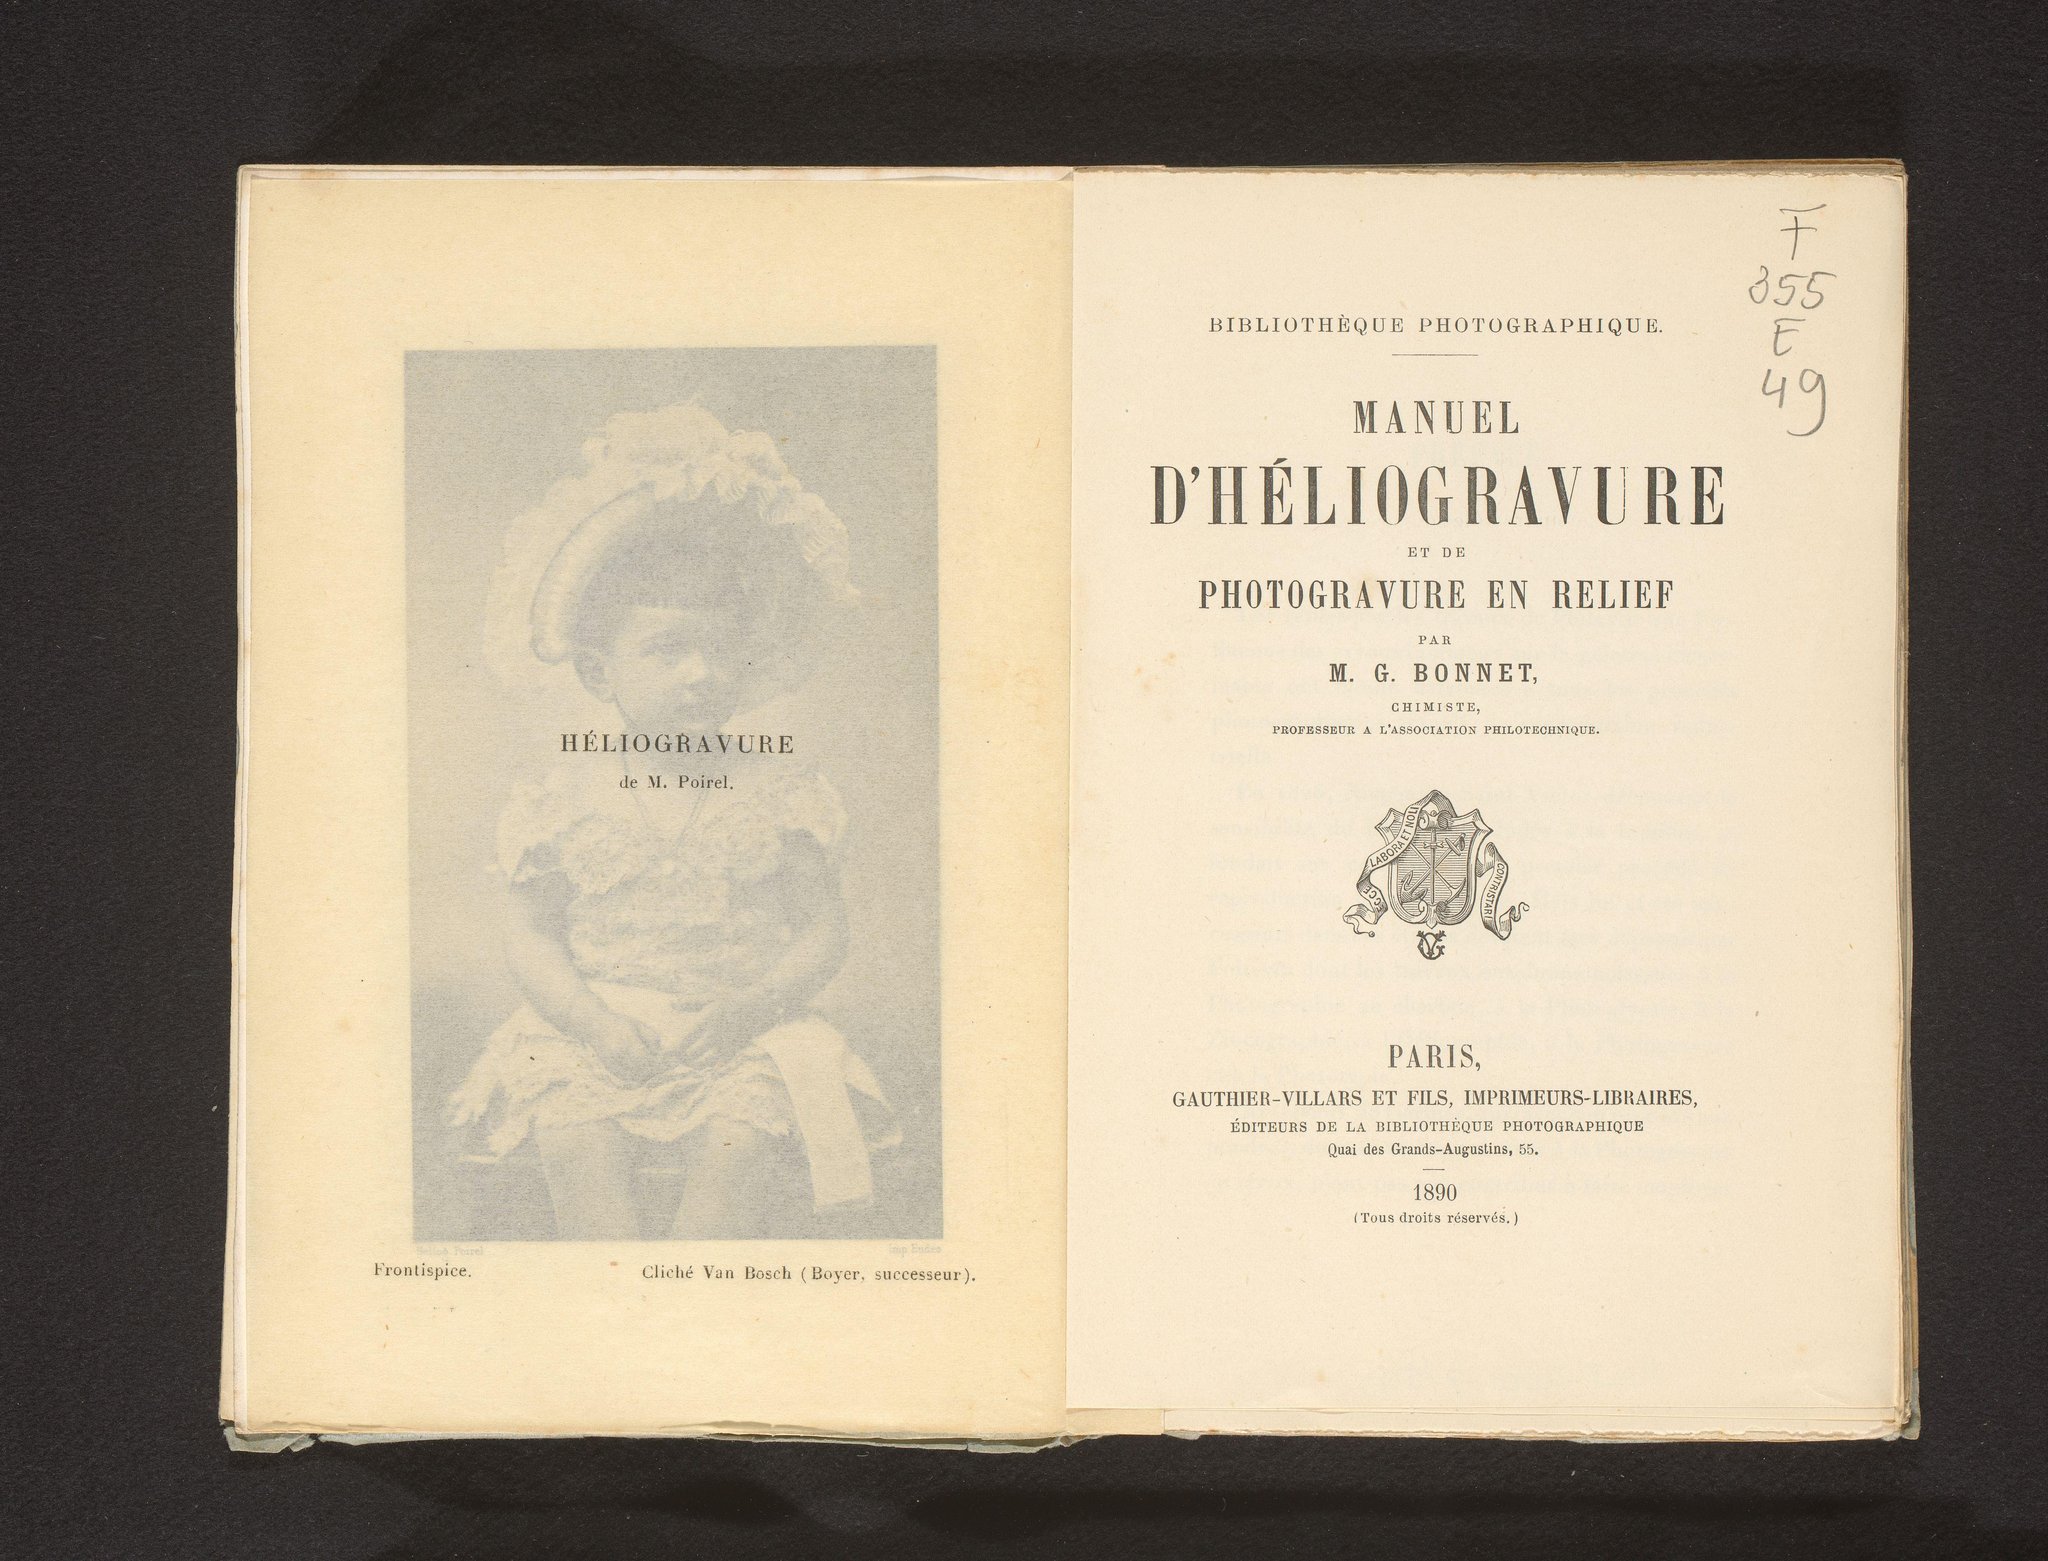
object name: book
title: Manuel d'héliogravure et de photogravure en relief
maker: m.g. bonnet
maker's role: chemicus, professor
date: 1890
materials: paper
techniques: photoaquatint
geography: paris